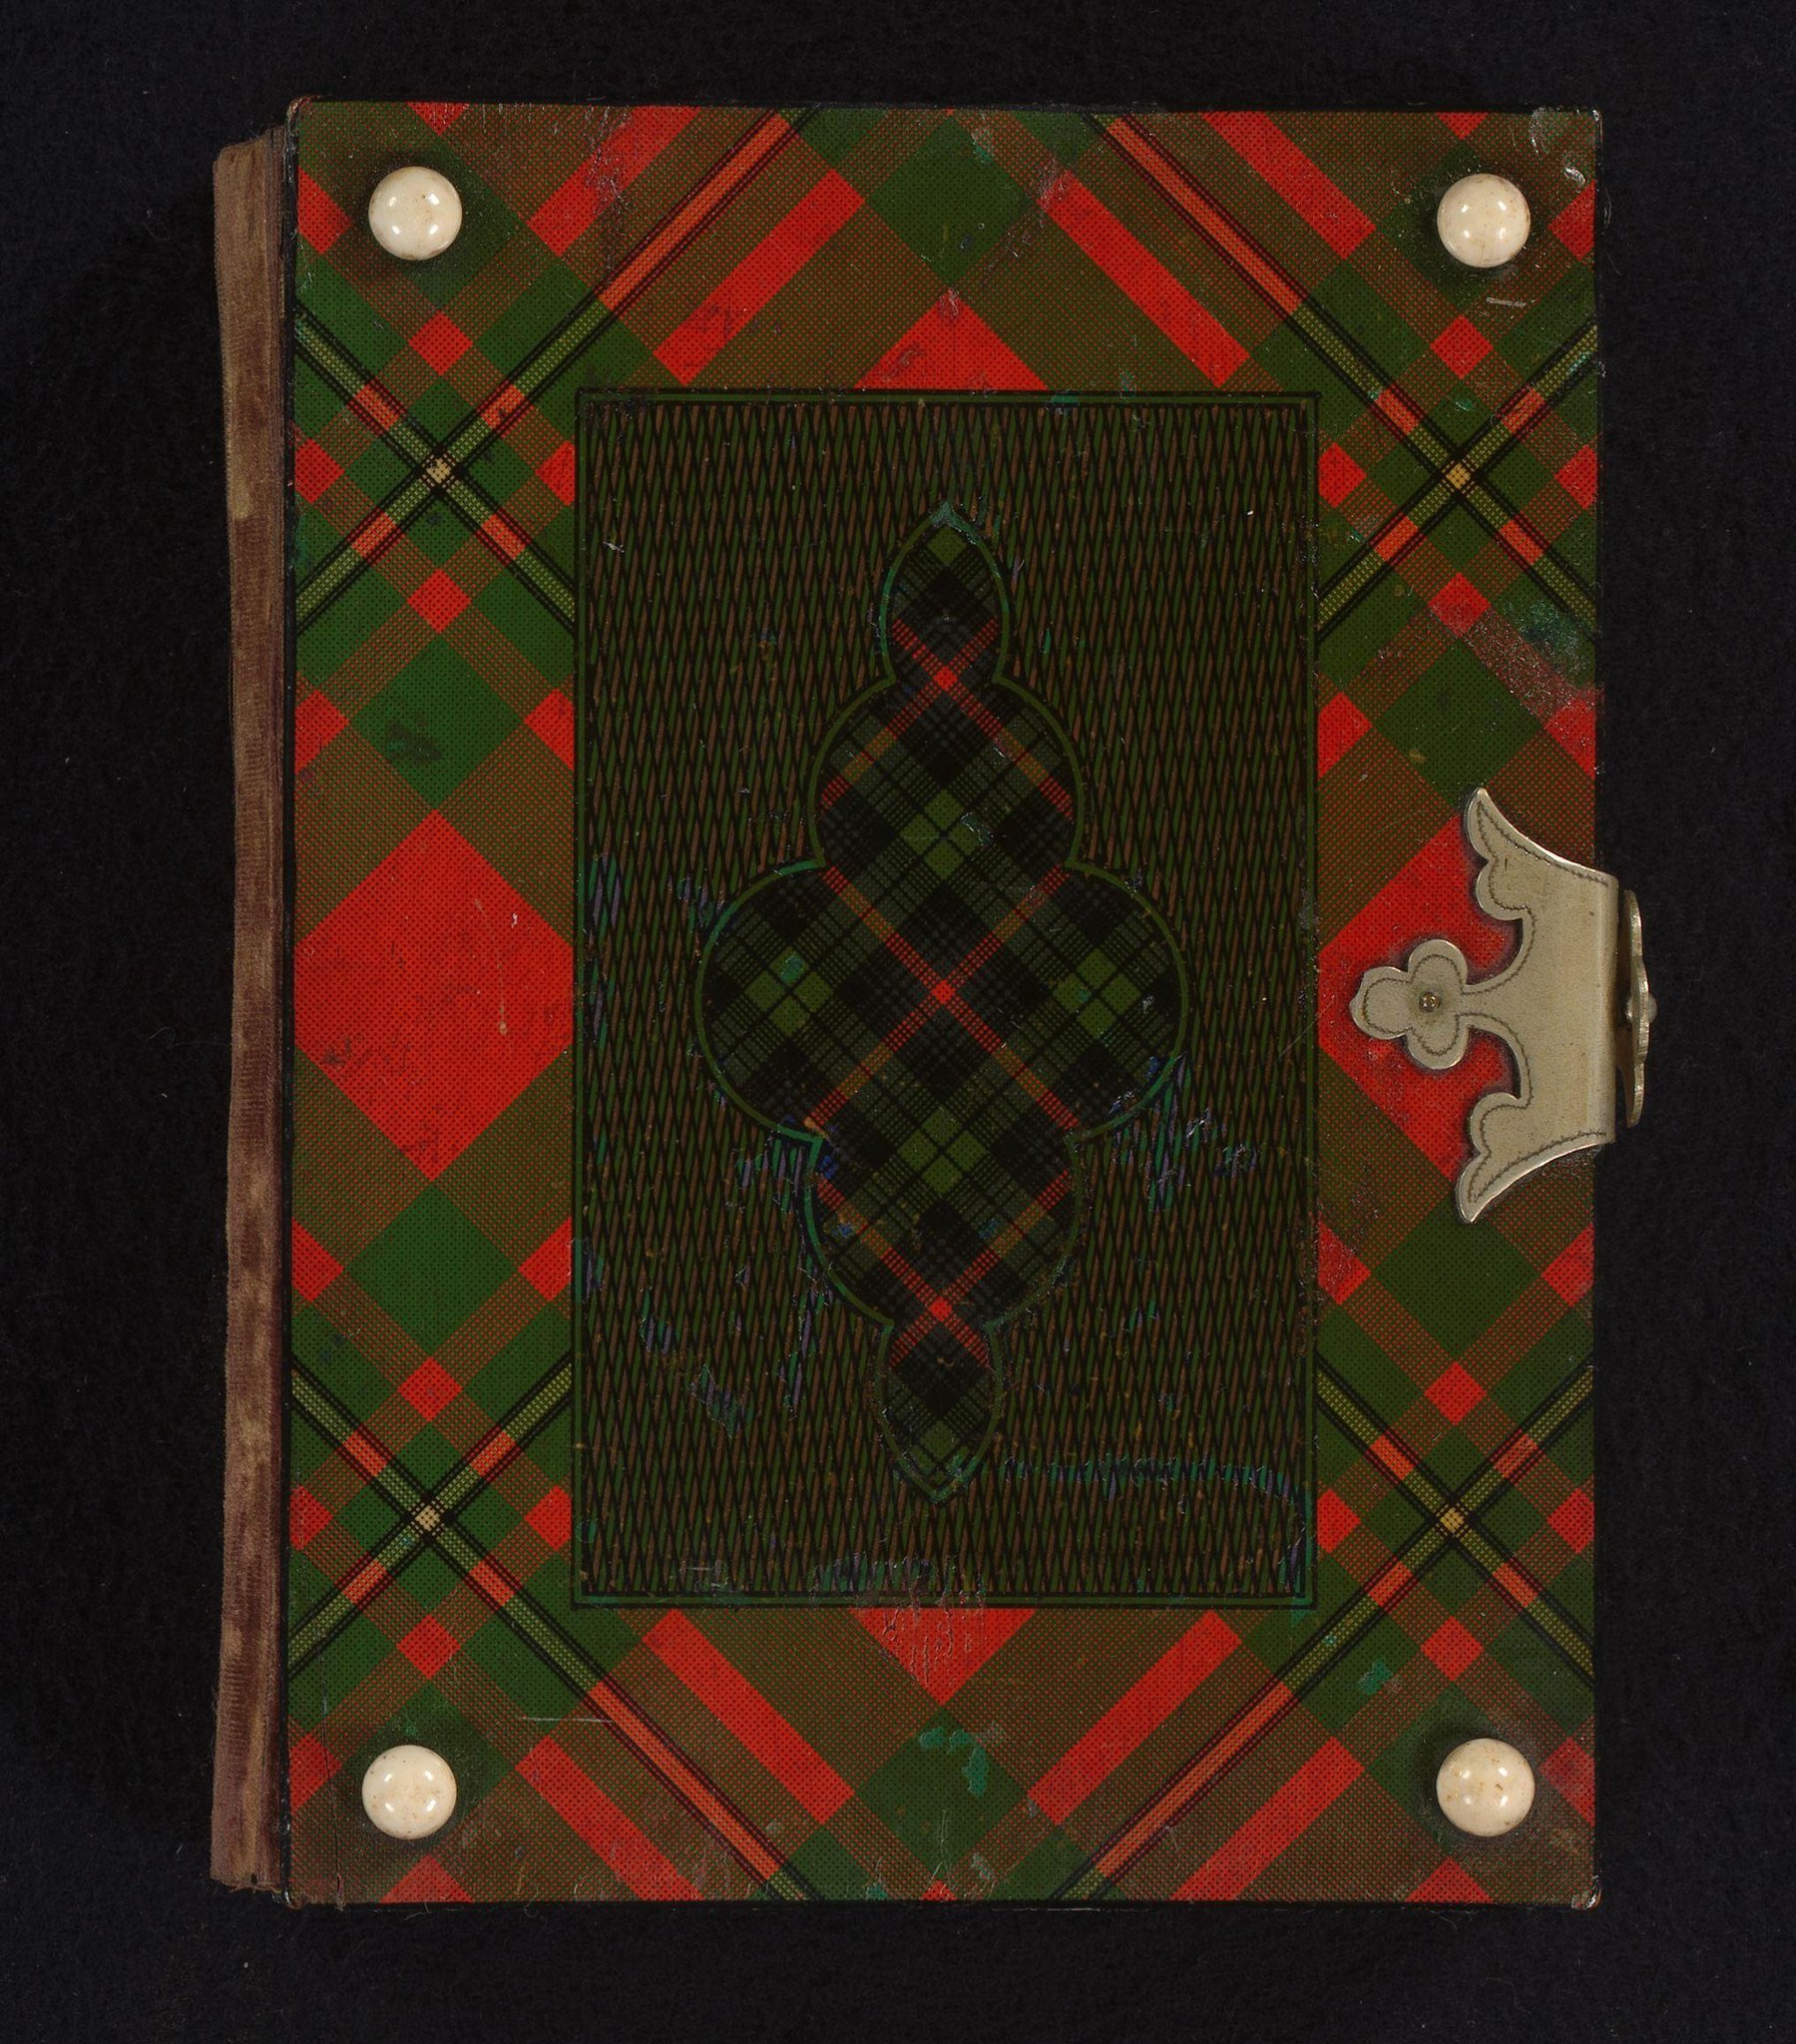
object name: photograph album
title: Fotoalbum (leeg)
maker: Anonymous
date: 1860-1900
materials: cardboard, lacquer, leather, metal, mother of pearl, paper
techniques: color on snow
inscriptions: annotation: ‘W 20/ [Swil] and green/ Y[I]-’, collector's mark: ‘DIENST/ VERSPREIDE/ RIJKSKOLLEKTIES/ (...) A 737’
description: Fotoalbum met twintig pagina's met op iedere pagina een rechthoekige of ovale passe-partout, met gouden lijnen omkaderd, voor een carte-de-visite.